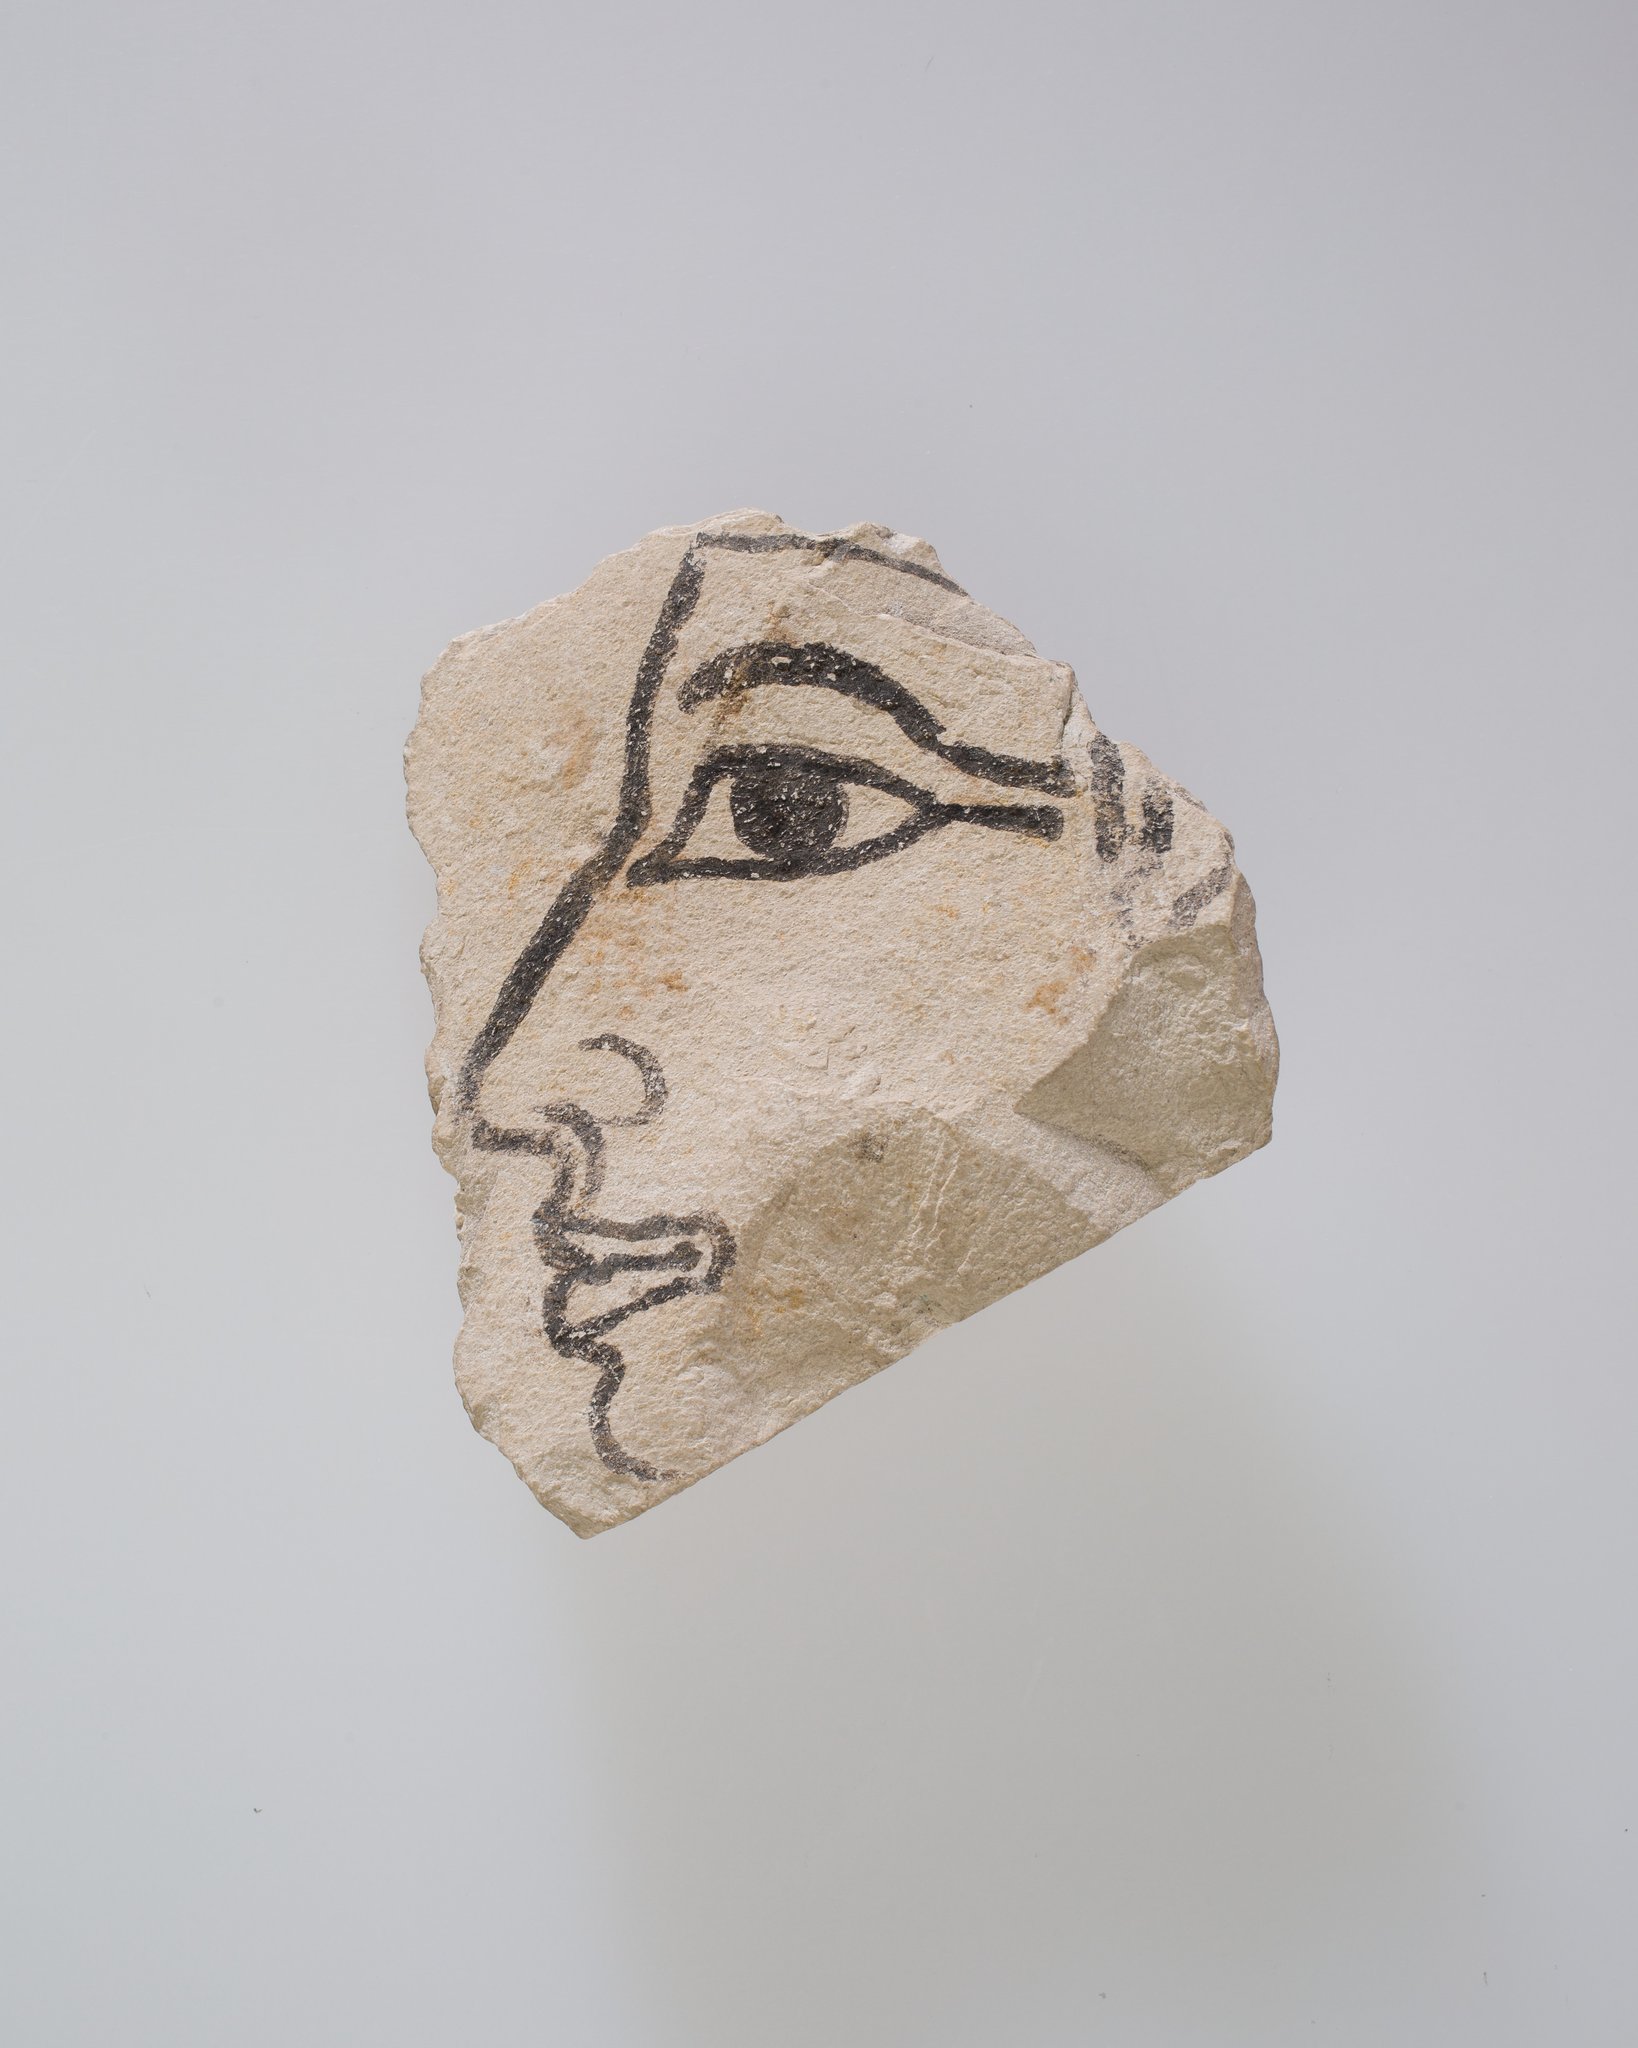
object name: ostracon, figured, senenmut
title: Ostracon with a Man's Profile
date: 1479-1458 BCE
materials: ink, limestone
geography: egypt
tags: men